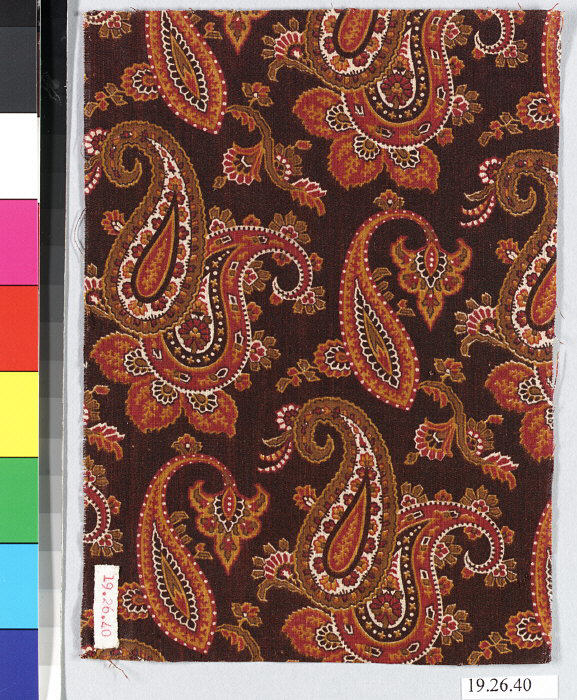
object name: sample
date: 1840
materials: cotton